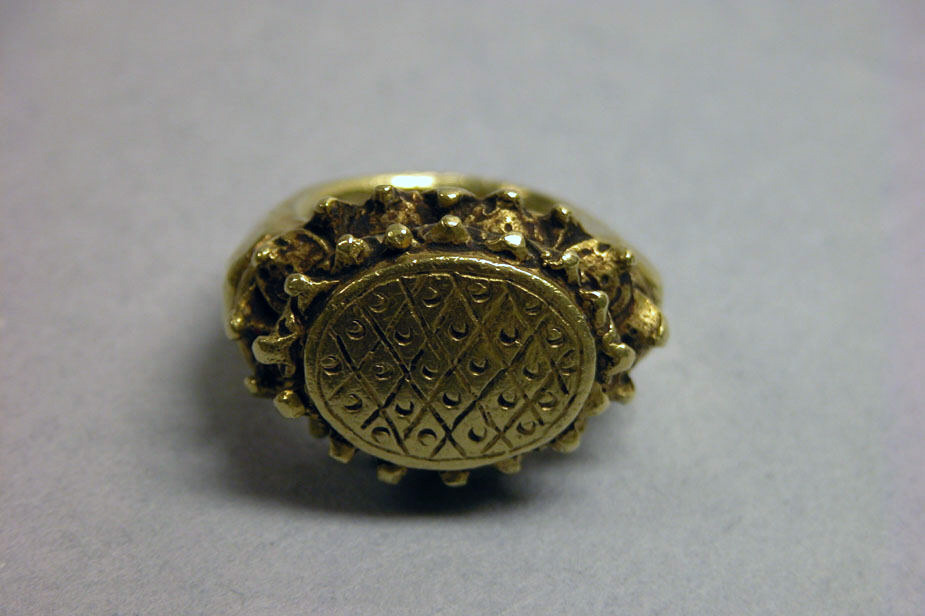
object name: ring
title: Stirrup-shaped Ring with Oval Bezel with Diaper Design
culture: indonesian, javanese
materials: gold